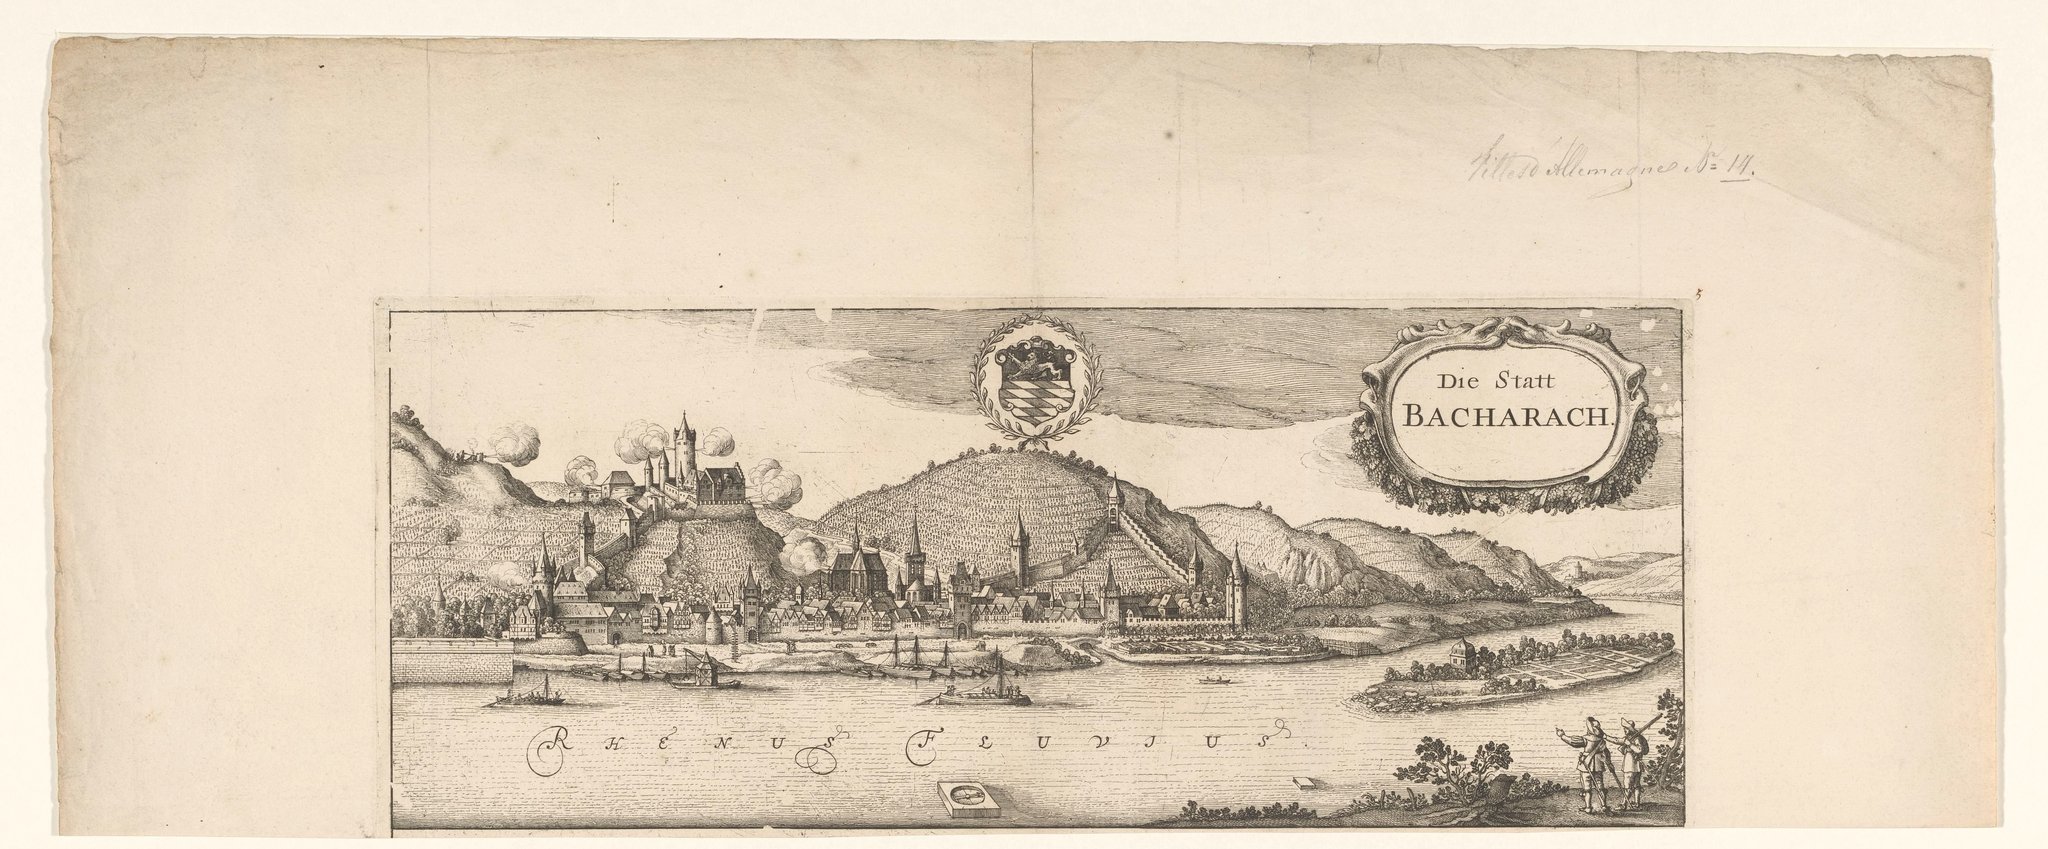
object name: print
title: Gezicht op Bacharach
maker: Anonymous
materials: paper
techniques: engraving, etching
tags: prospect of city, town panorama, silhouette of city, armorial bearing, heraldry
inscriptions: collector's mark: Lugt 2228